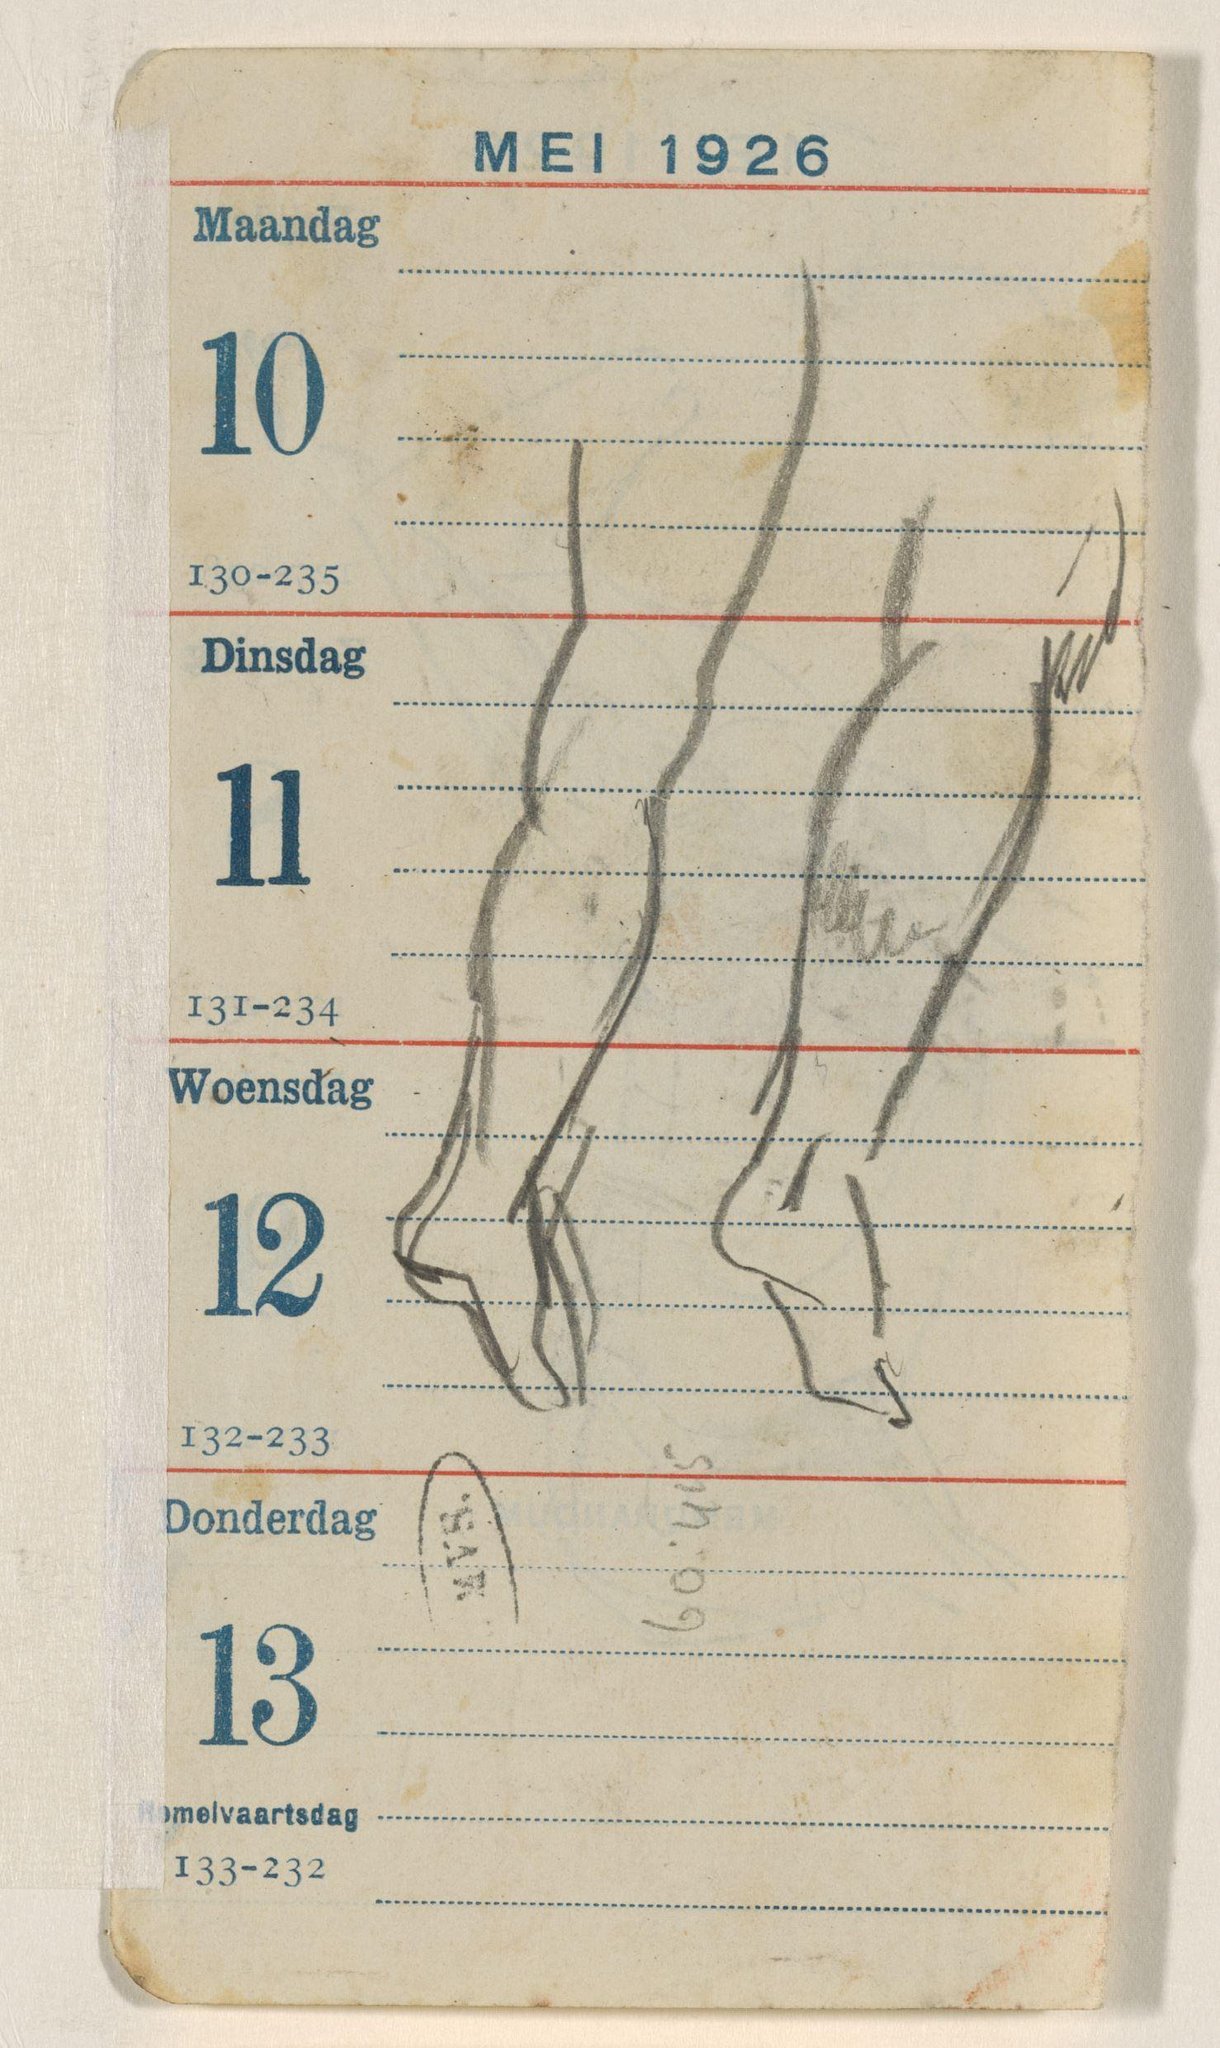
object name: drawing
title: Twee benen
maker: leo gestel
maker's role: draughtsman, print maker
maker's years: 1881-1941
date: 1926-1941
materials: paper, pencil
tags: legs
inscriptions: collector's mark: Lugt 2228